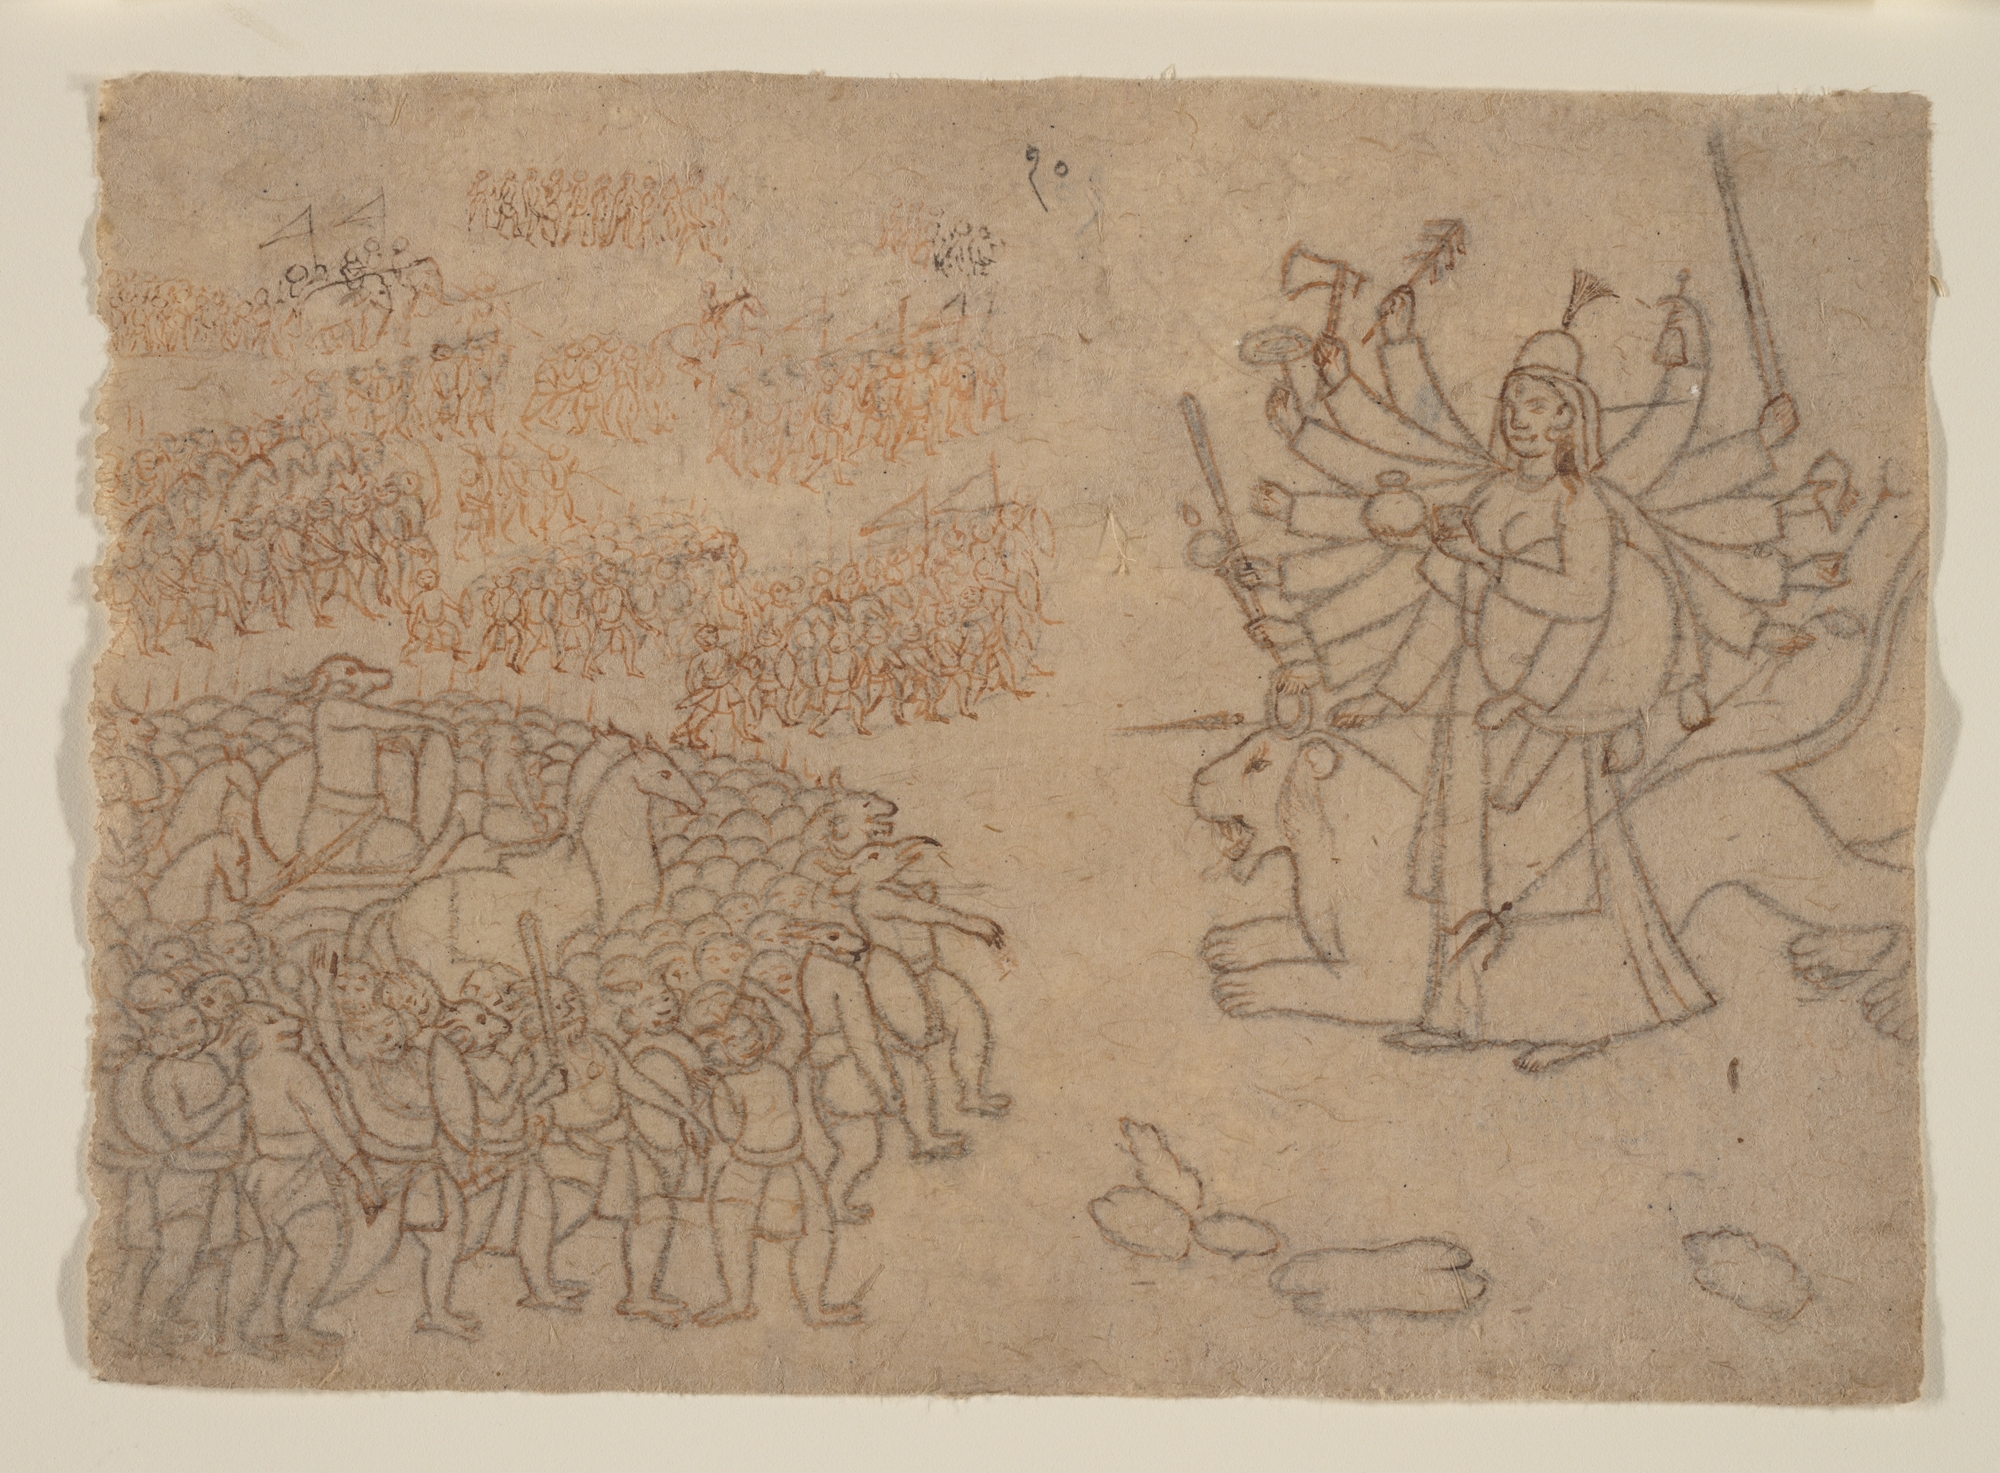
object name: painting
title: Durga Confronts the Army of the Demon Chikshura: Scene from the Devi Mahatmya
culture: indian, guler, himachal pradesh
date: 1780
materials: charcoal, paper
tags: army,horses,lions,demons,durga,hinduism